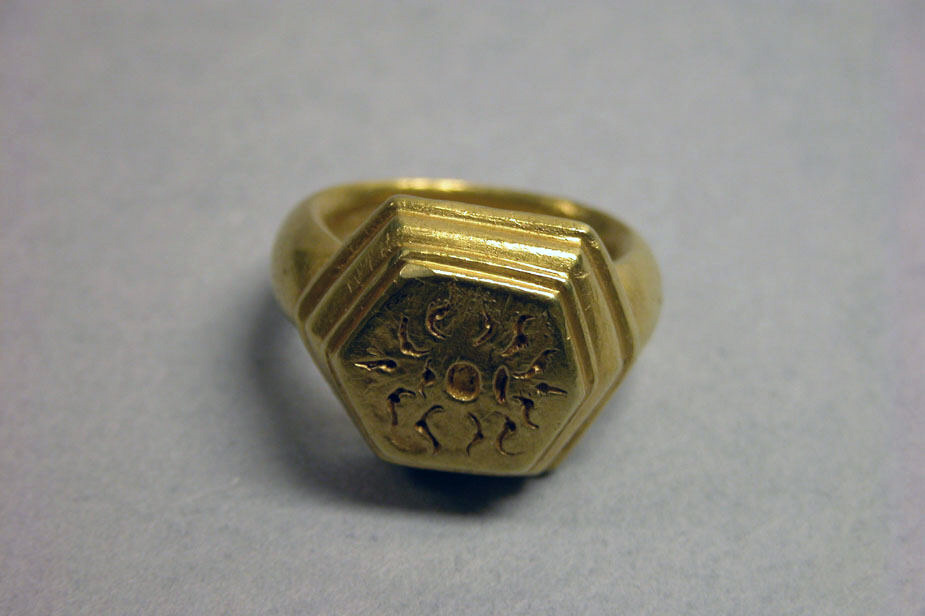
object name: ring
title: Ring with Circular Bezel and "Sri" Inscription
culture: indonesian, javanese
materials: gold